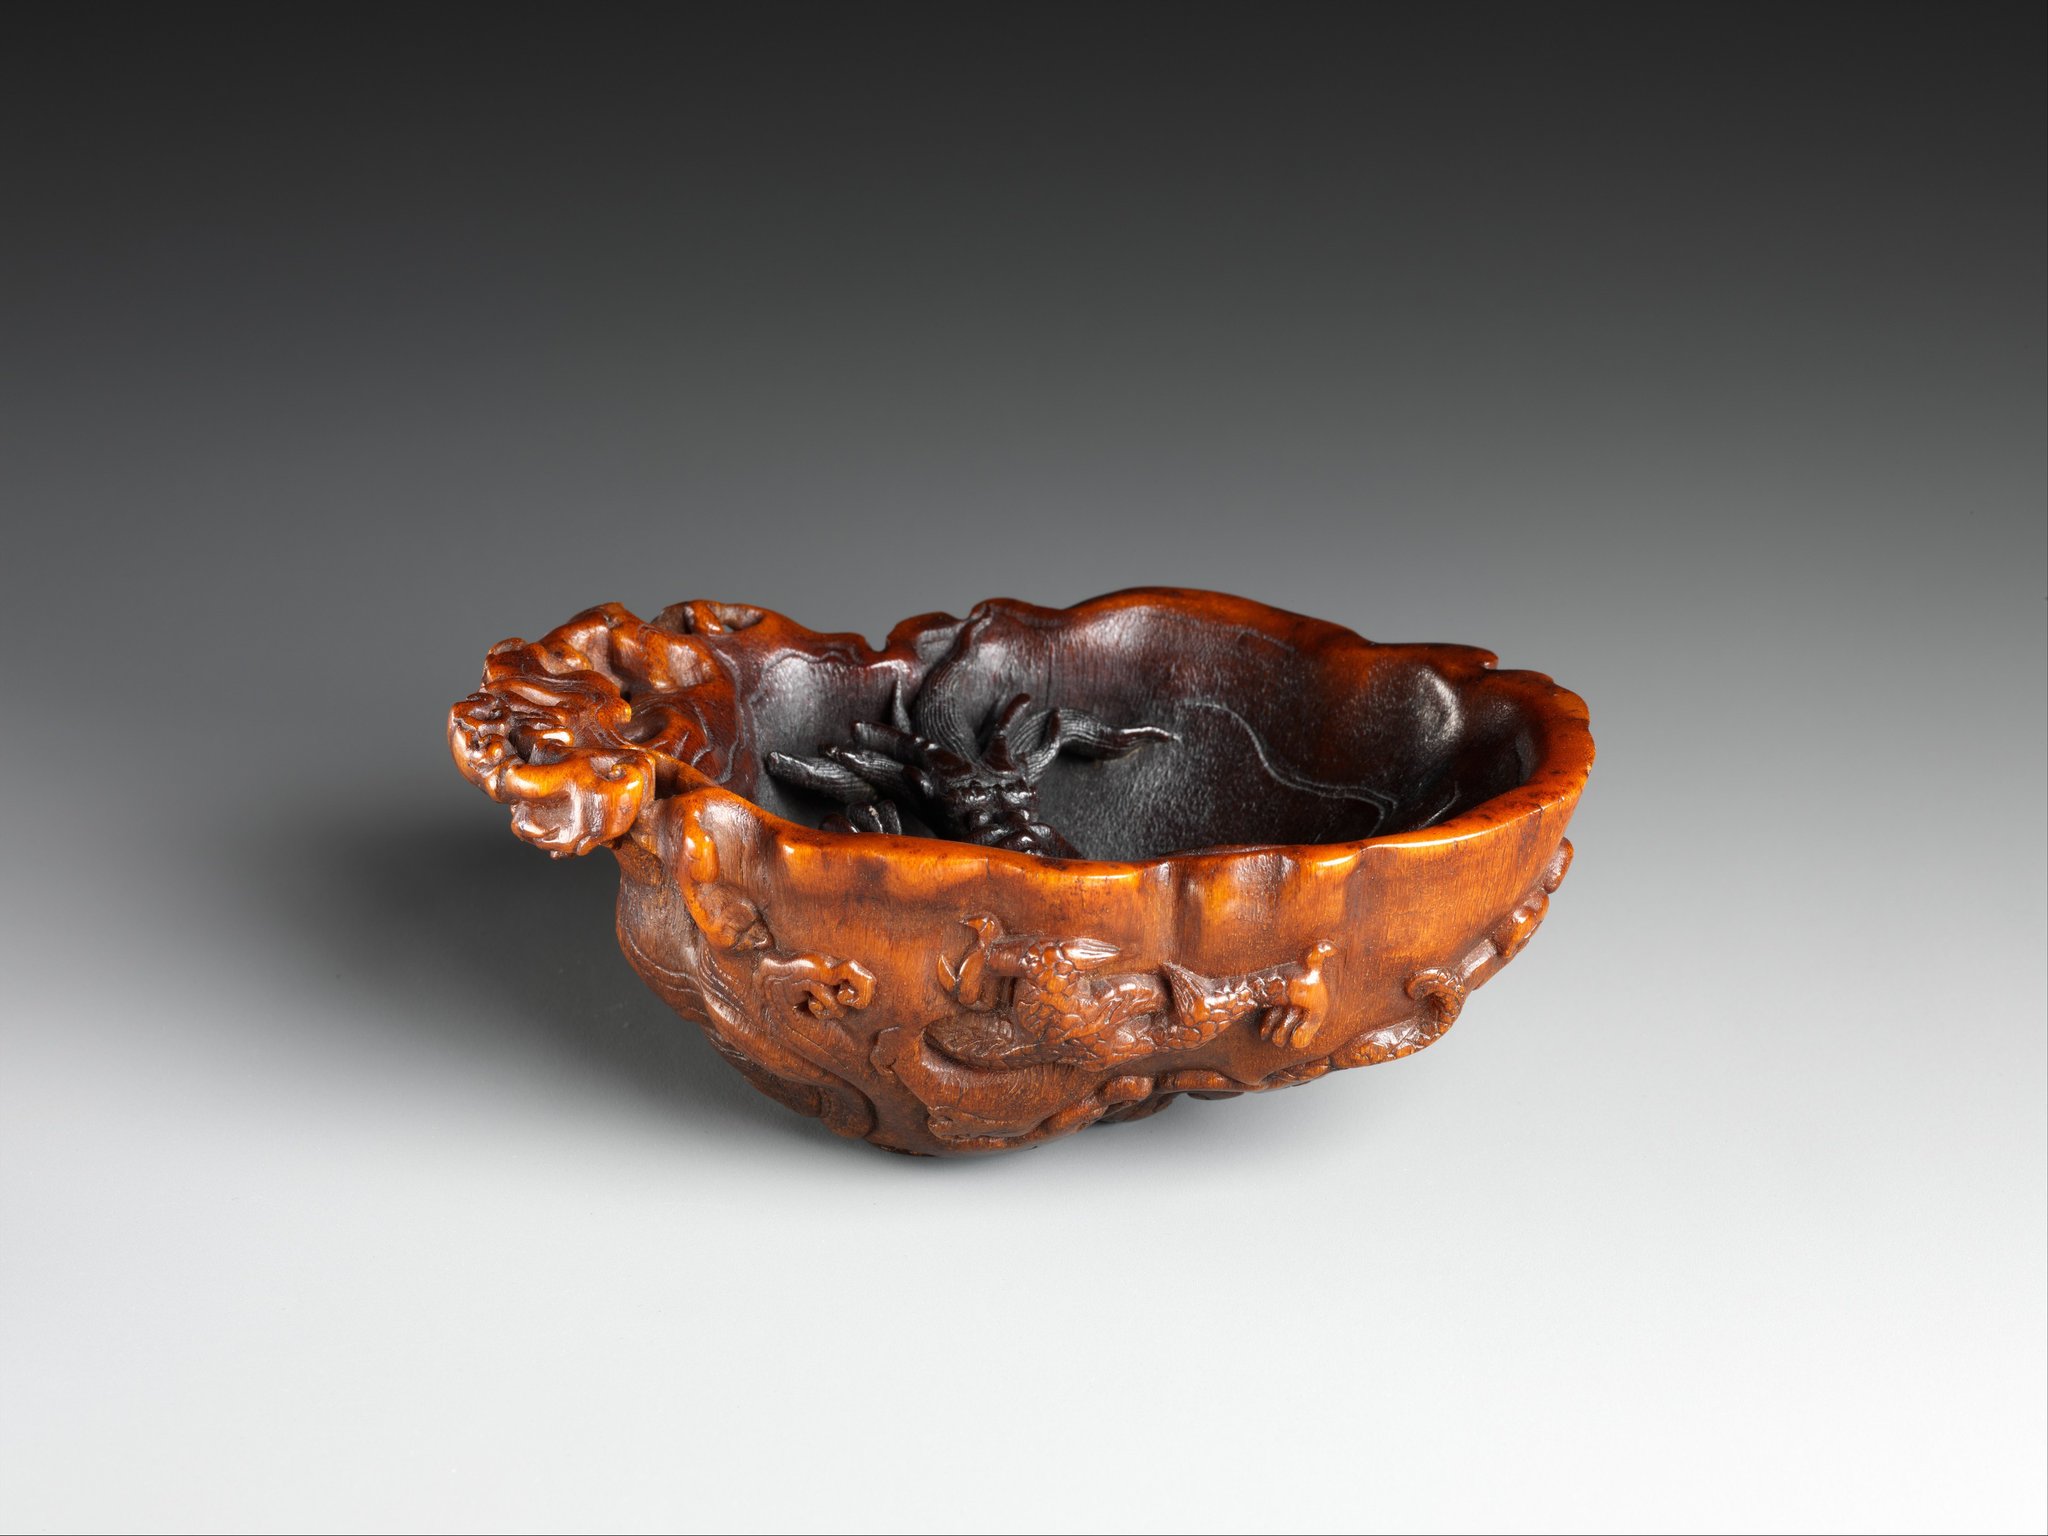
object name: cup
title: Cup with two dragons in waves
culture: chinese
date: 1601-1700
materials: horn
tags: dragons